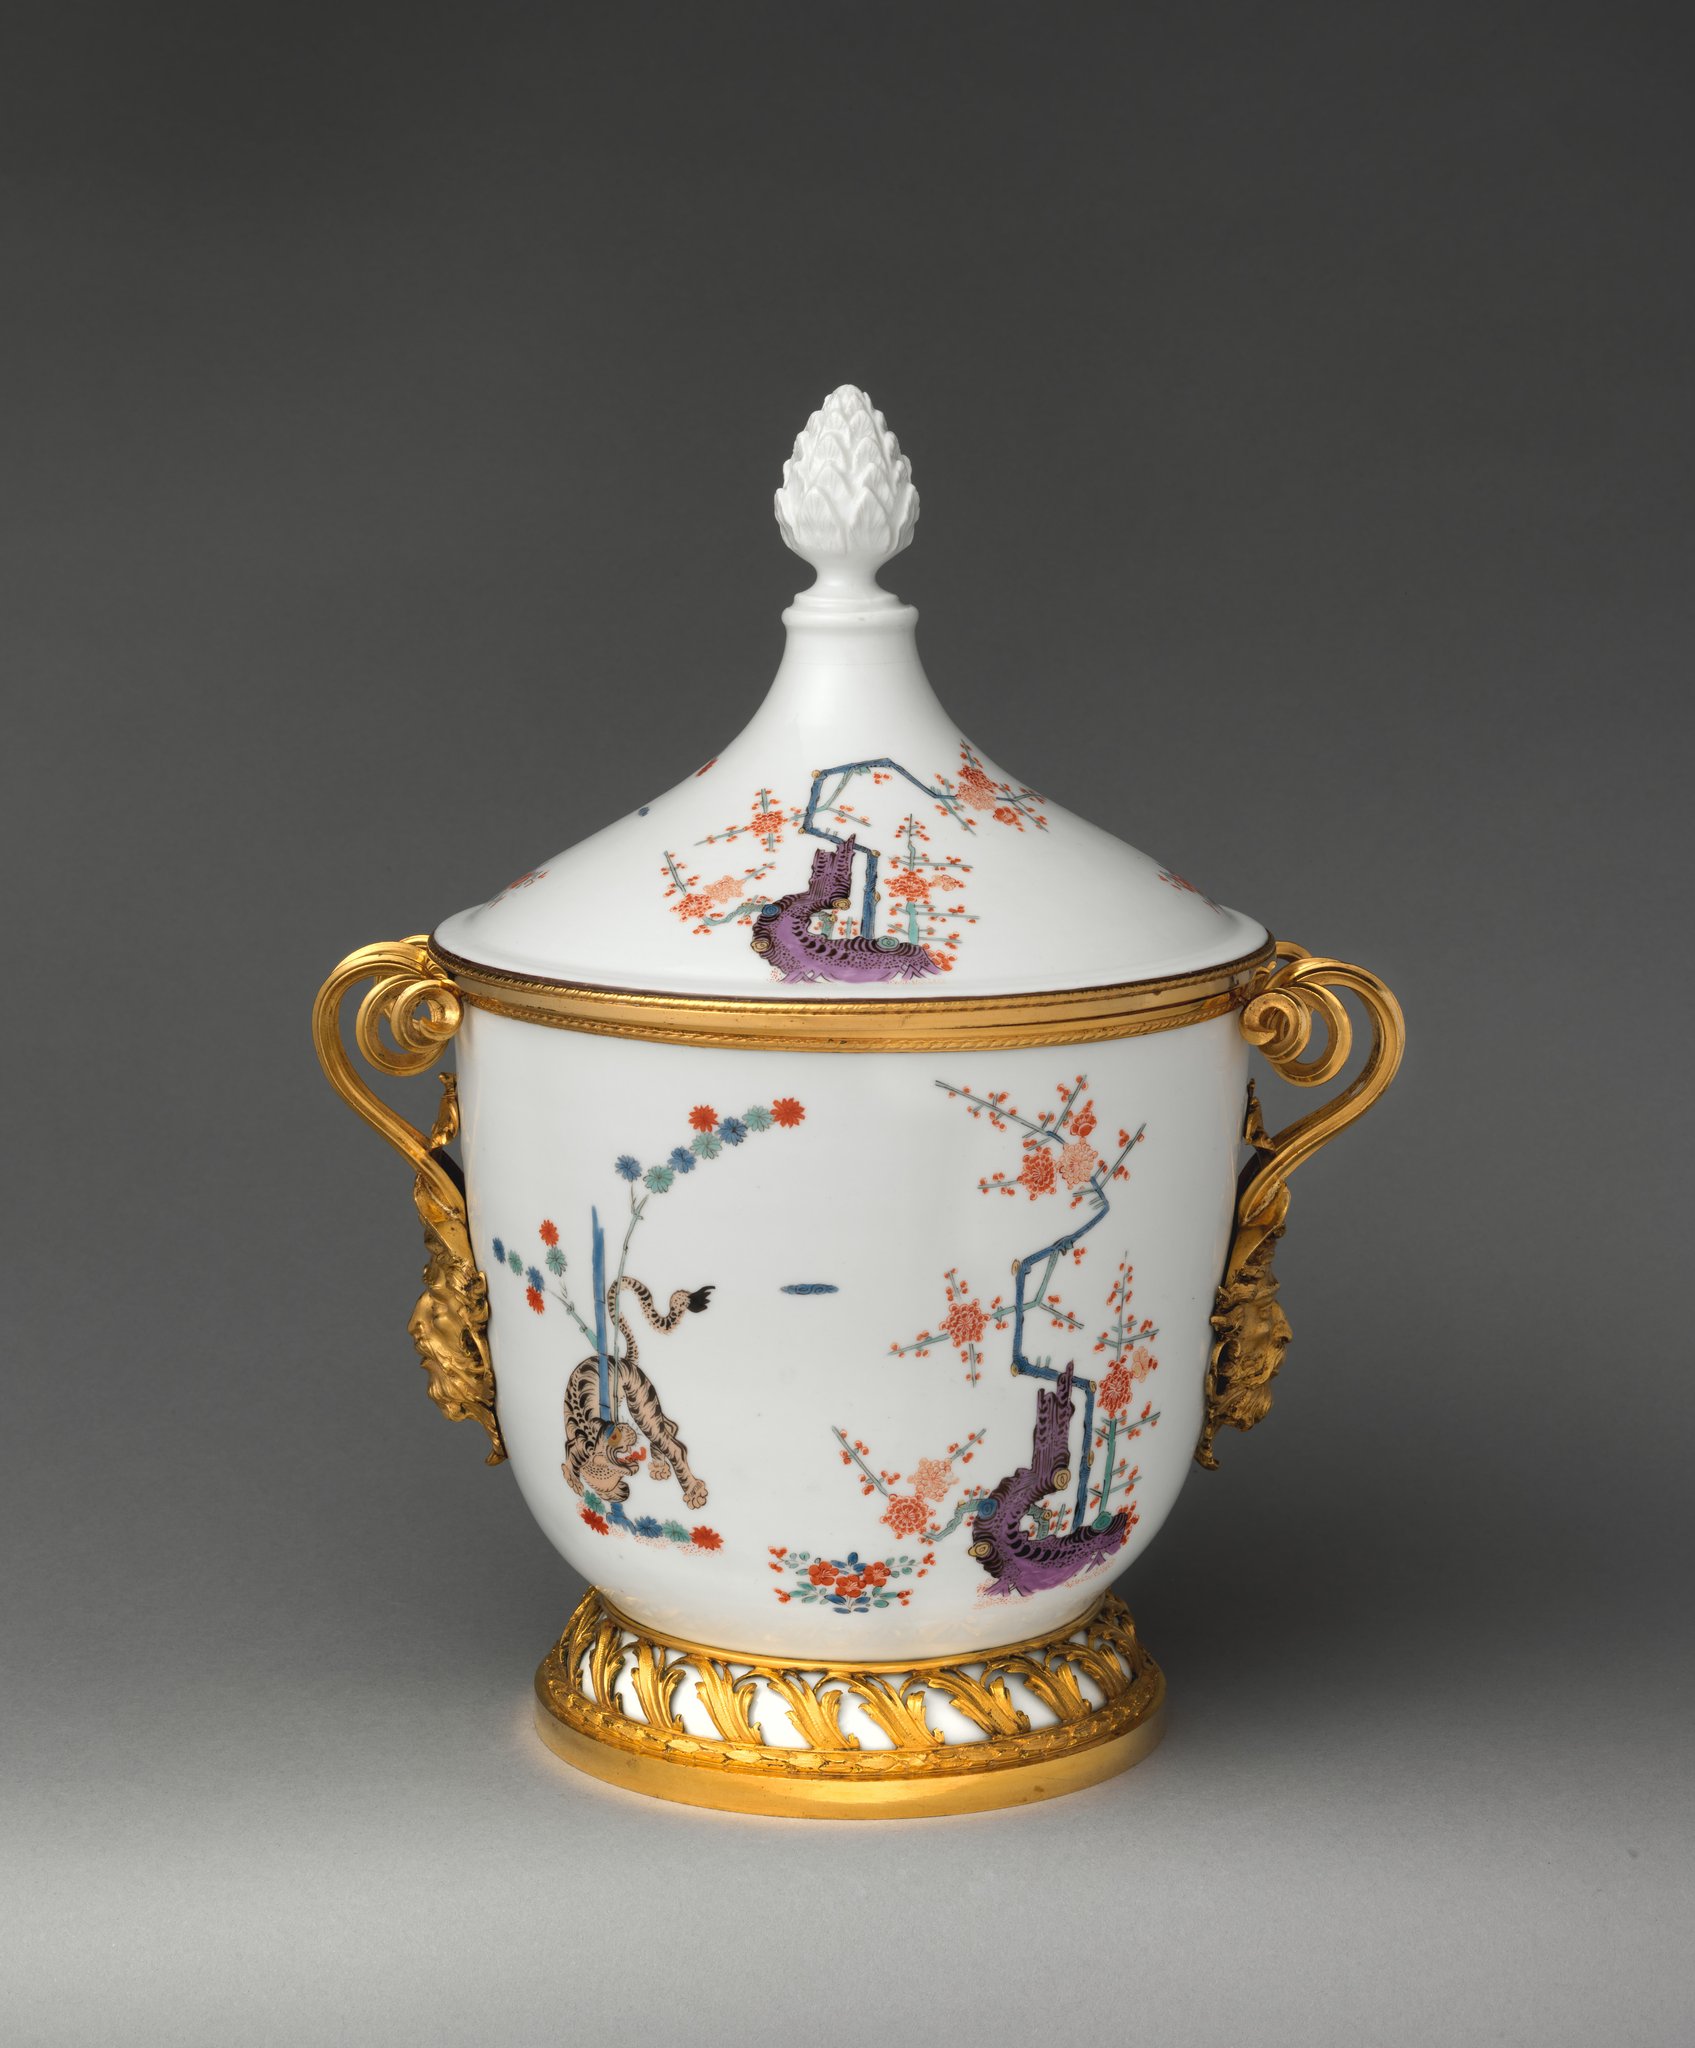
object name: ice cream pail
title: Ice cream pail (one of a pair)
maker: meissen manufactory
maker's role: manufactory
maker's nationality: german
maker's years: 1710-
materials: gilt bronze, hard paste porcelain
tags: faces,tigers,flowers